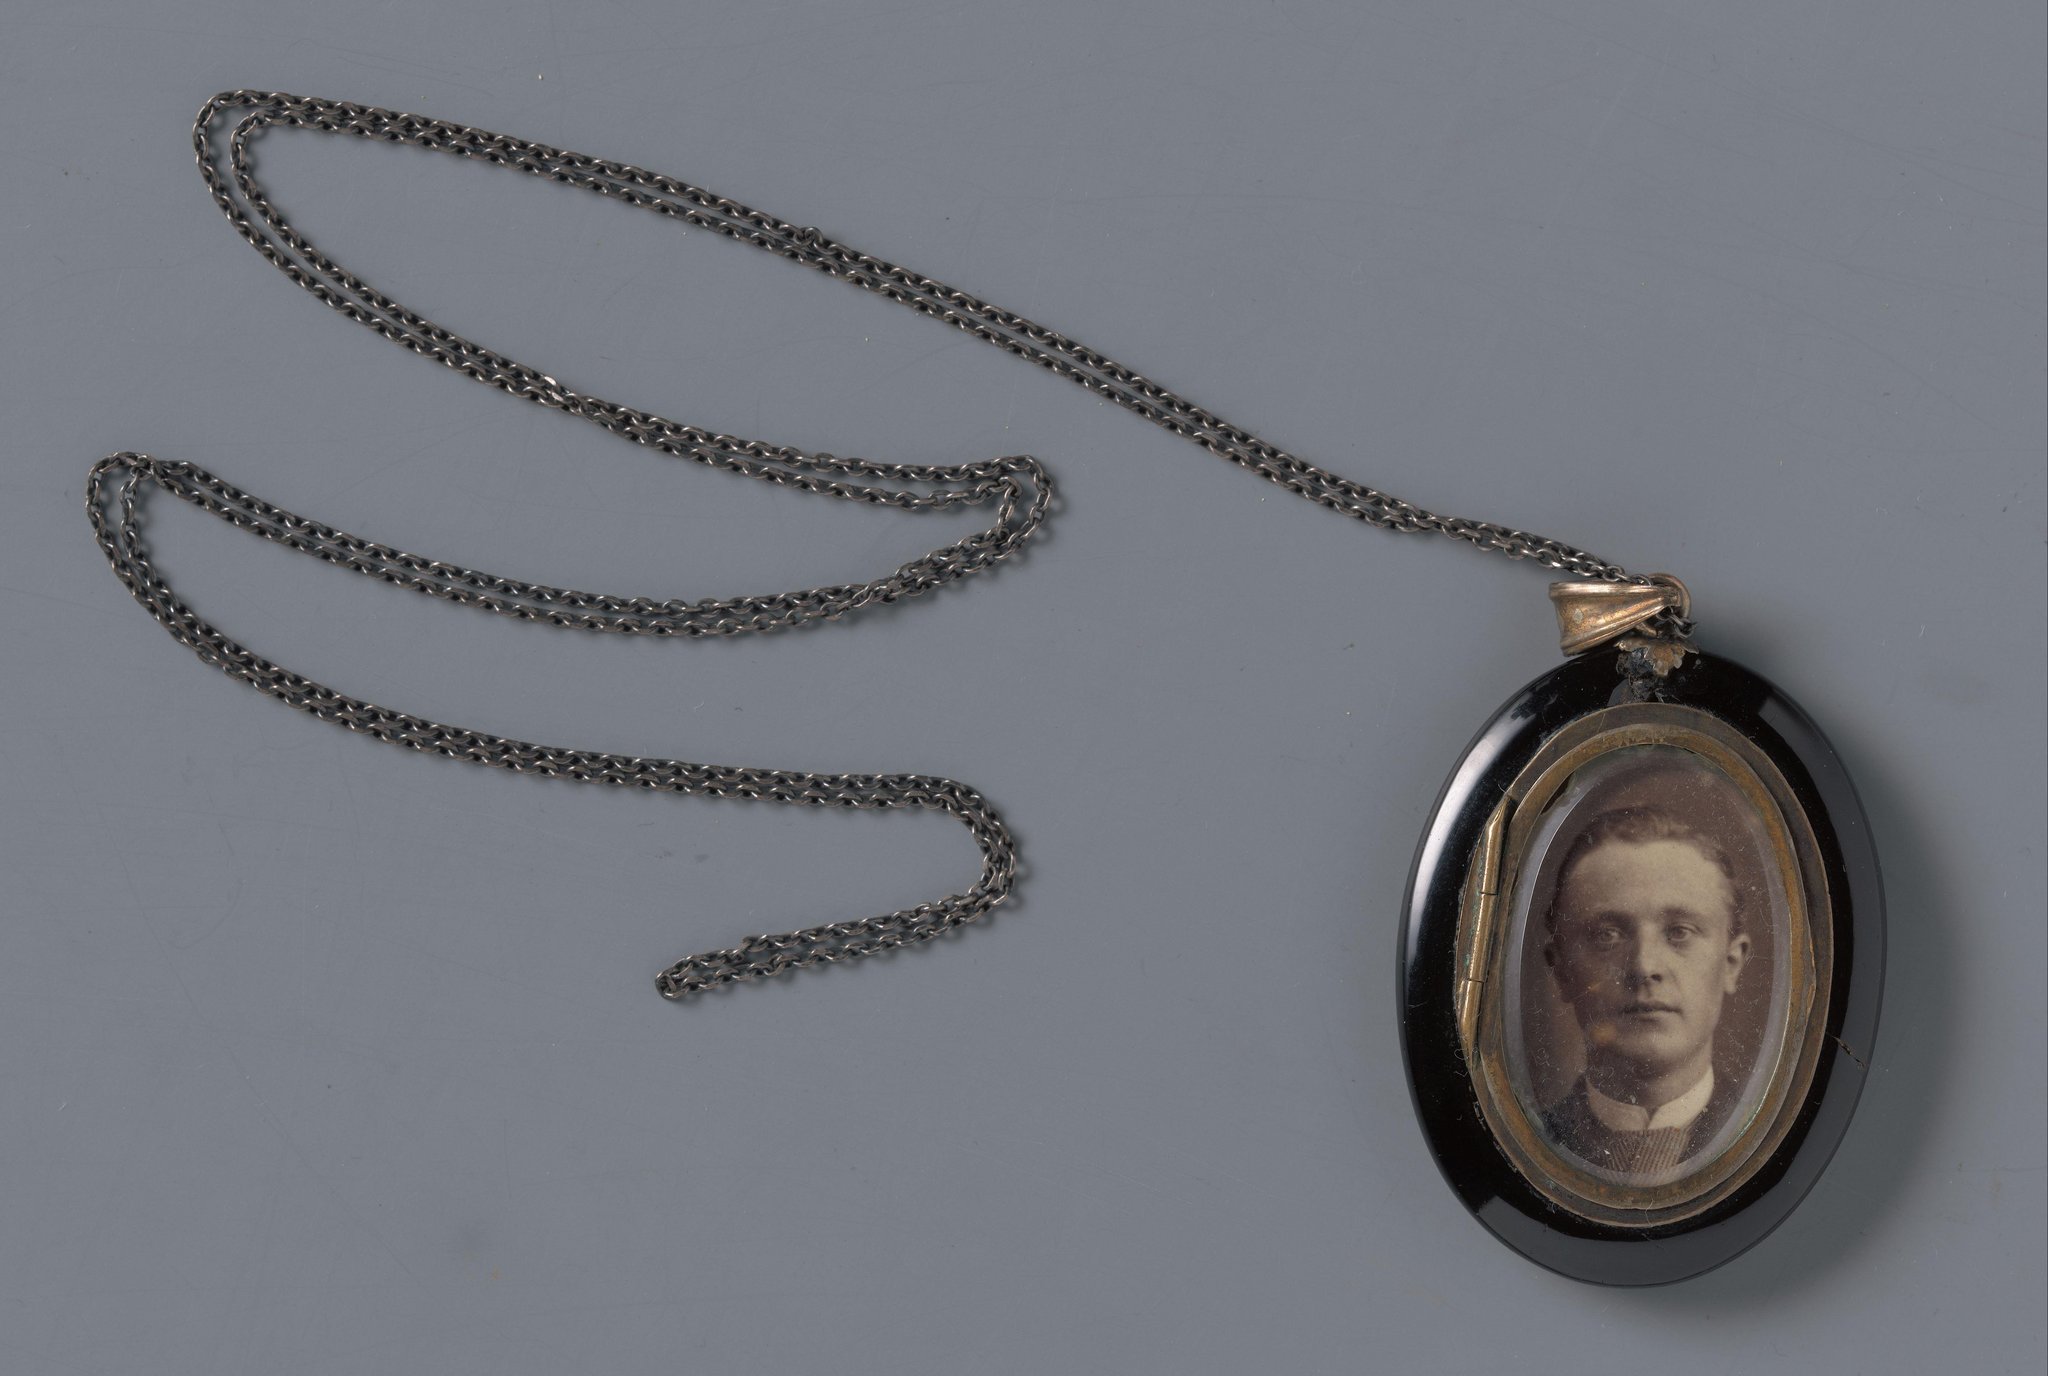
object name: photograph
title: Portret van een onbekende man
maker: Anonymous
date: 1880-1900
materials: glass, metal, photographic support, plastic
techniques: albumen print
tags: historical persons